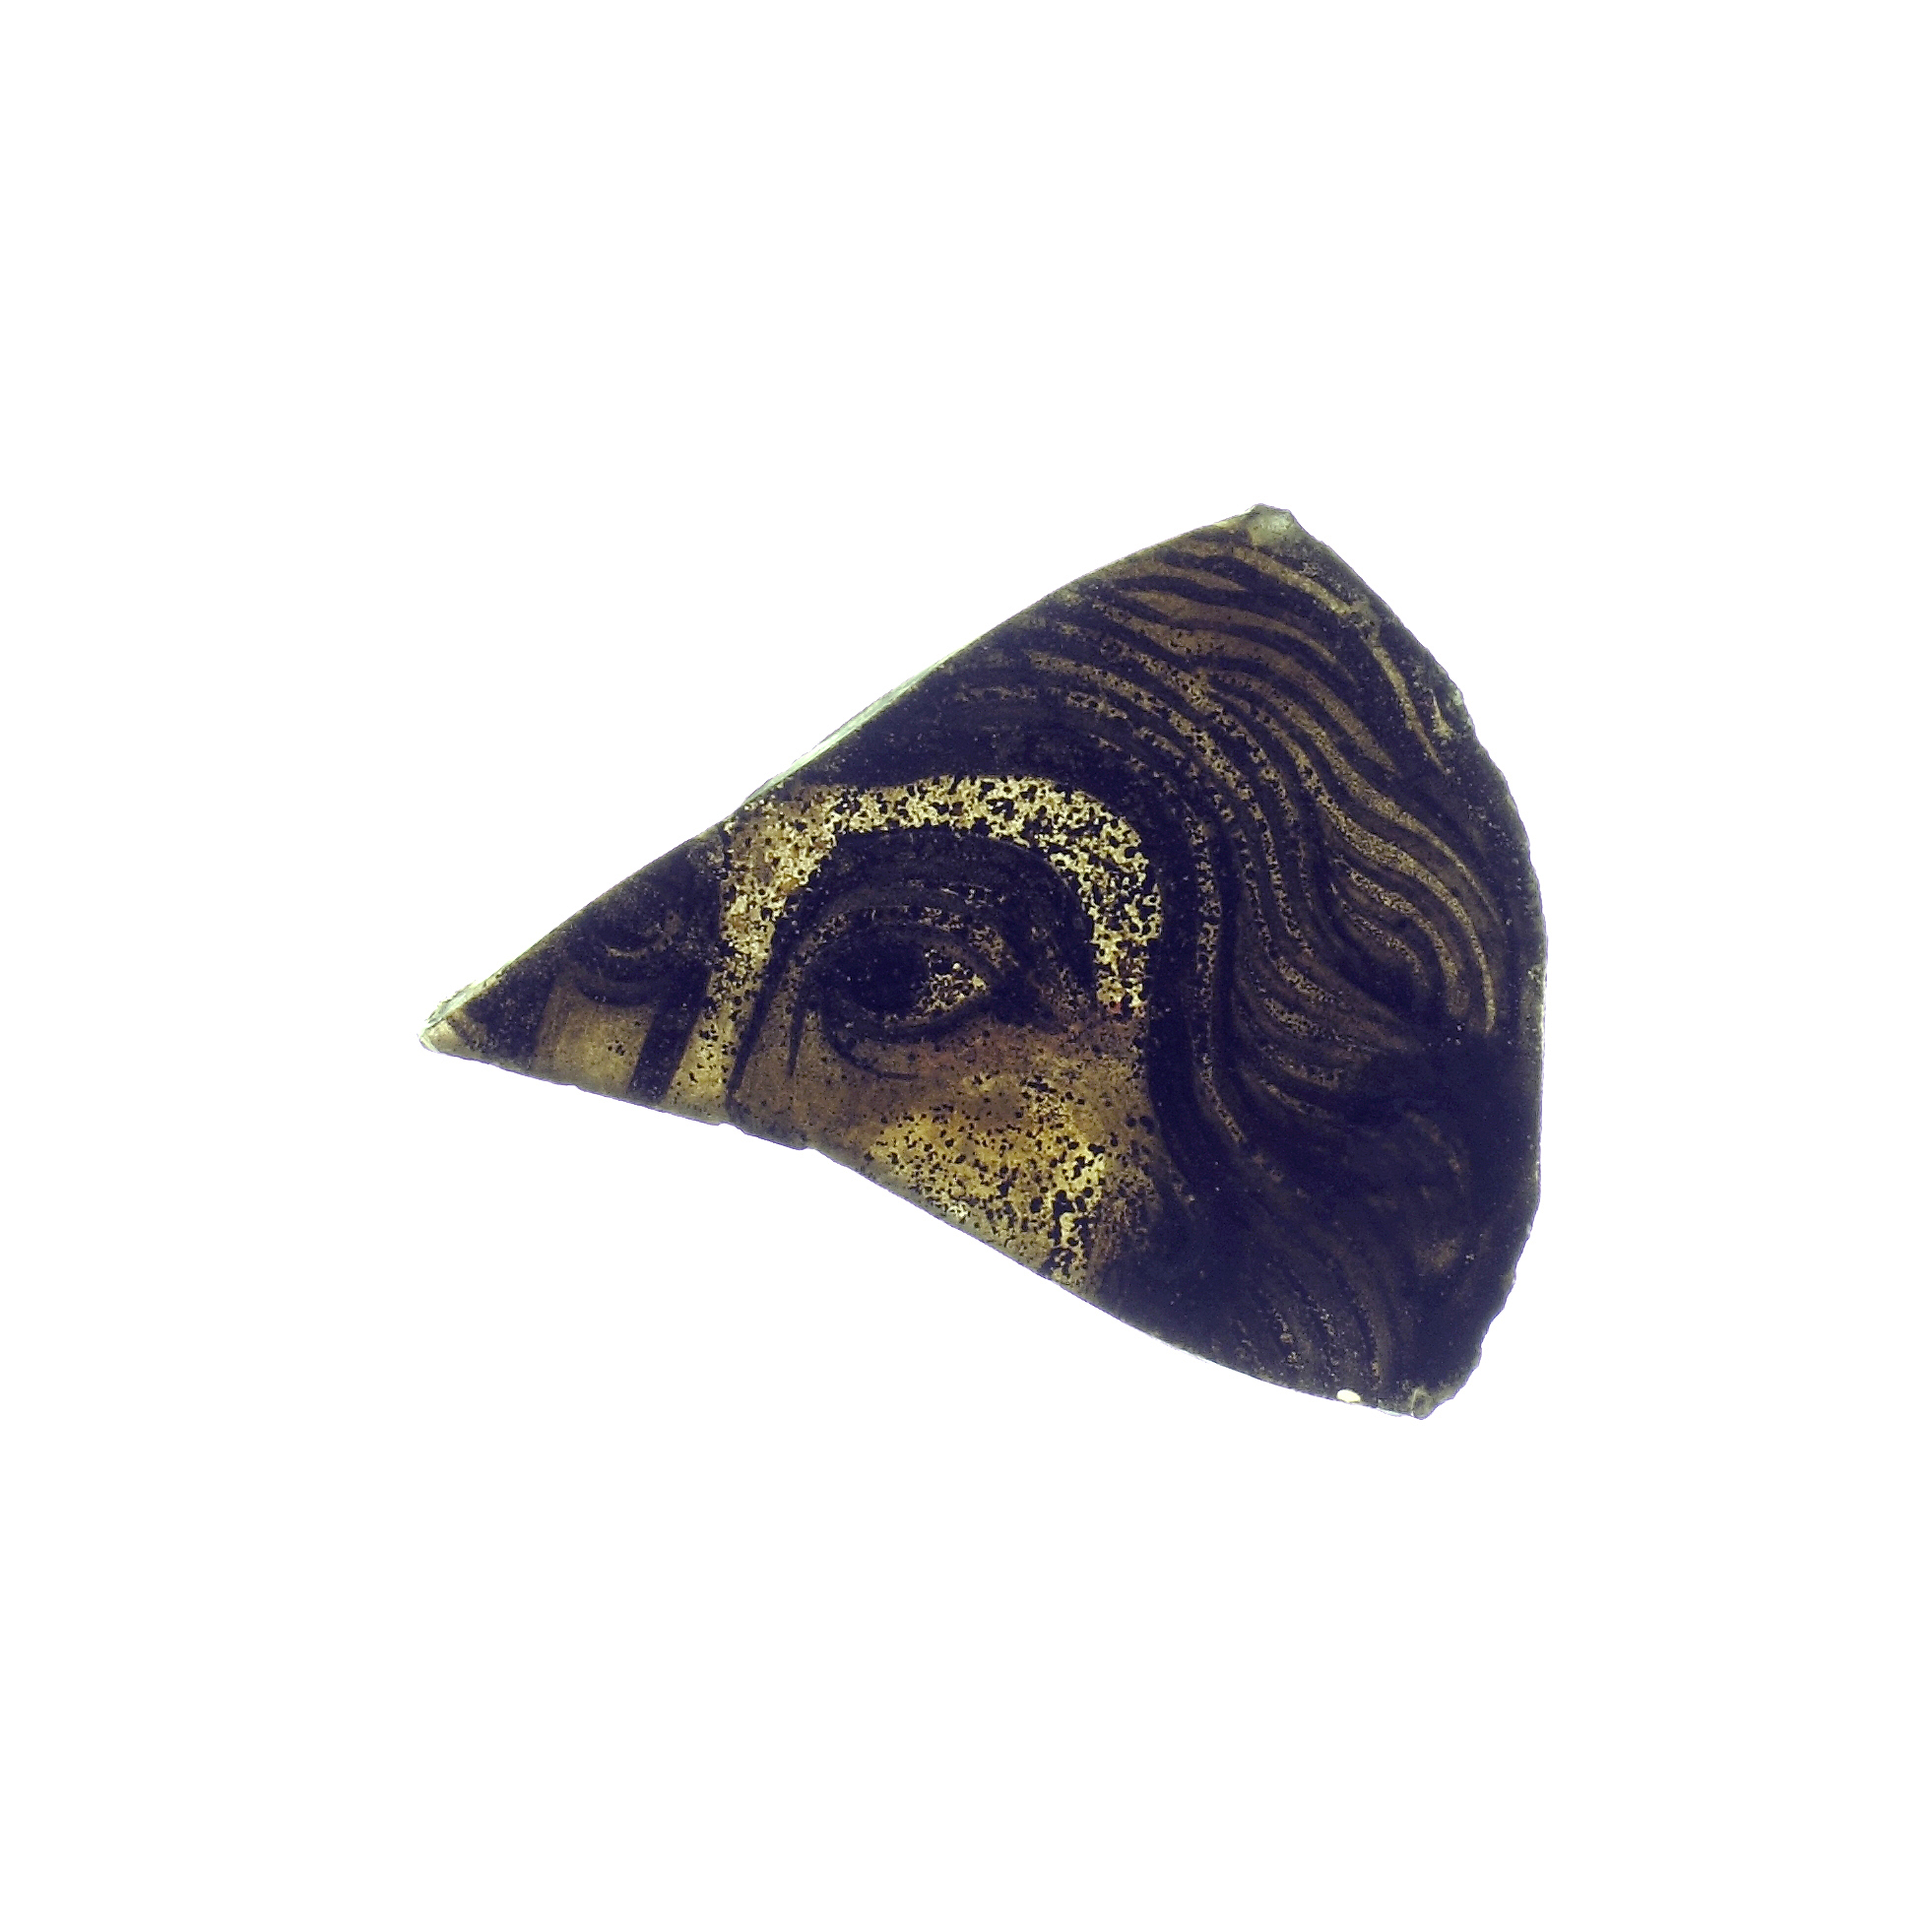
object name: fragment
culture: french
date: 1101-1400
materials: glass, metal, paint